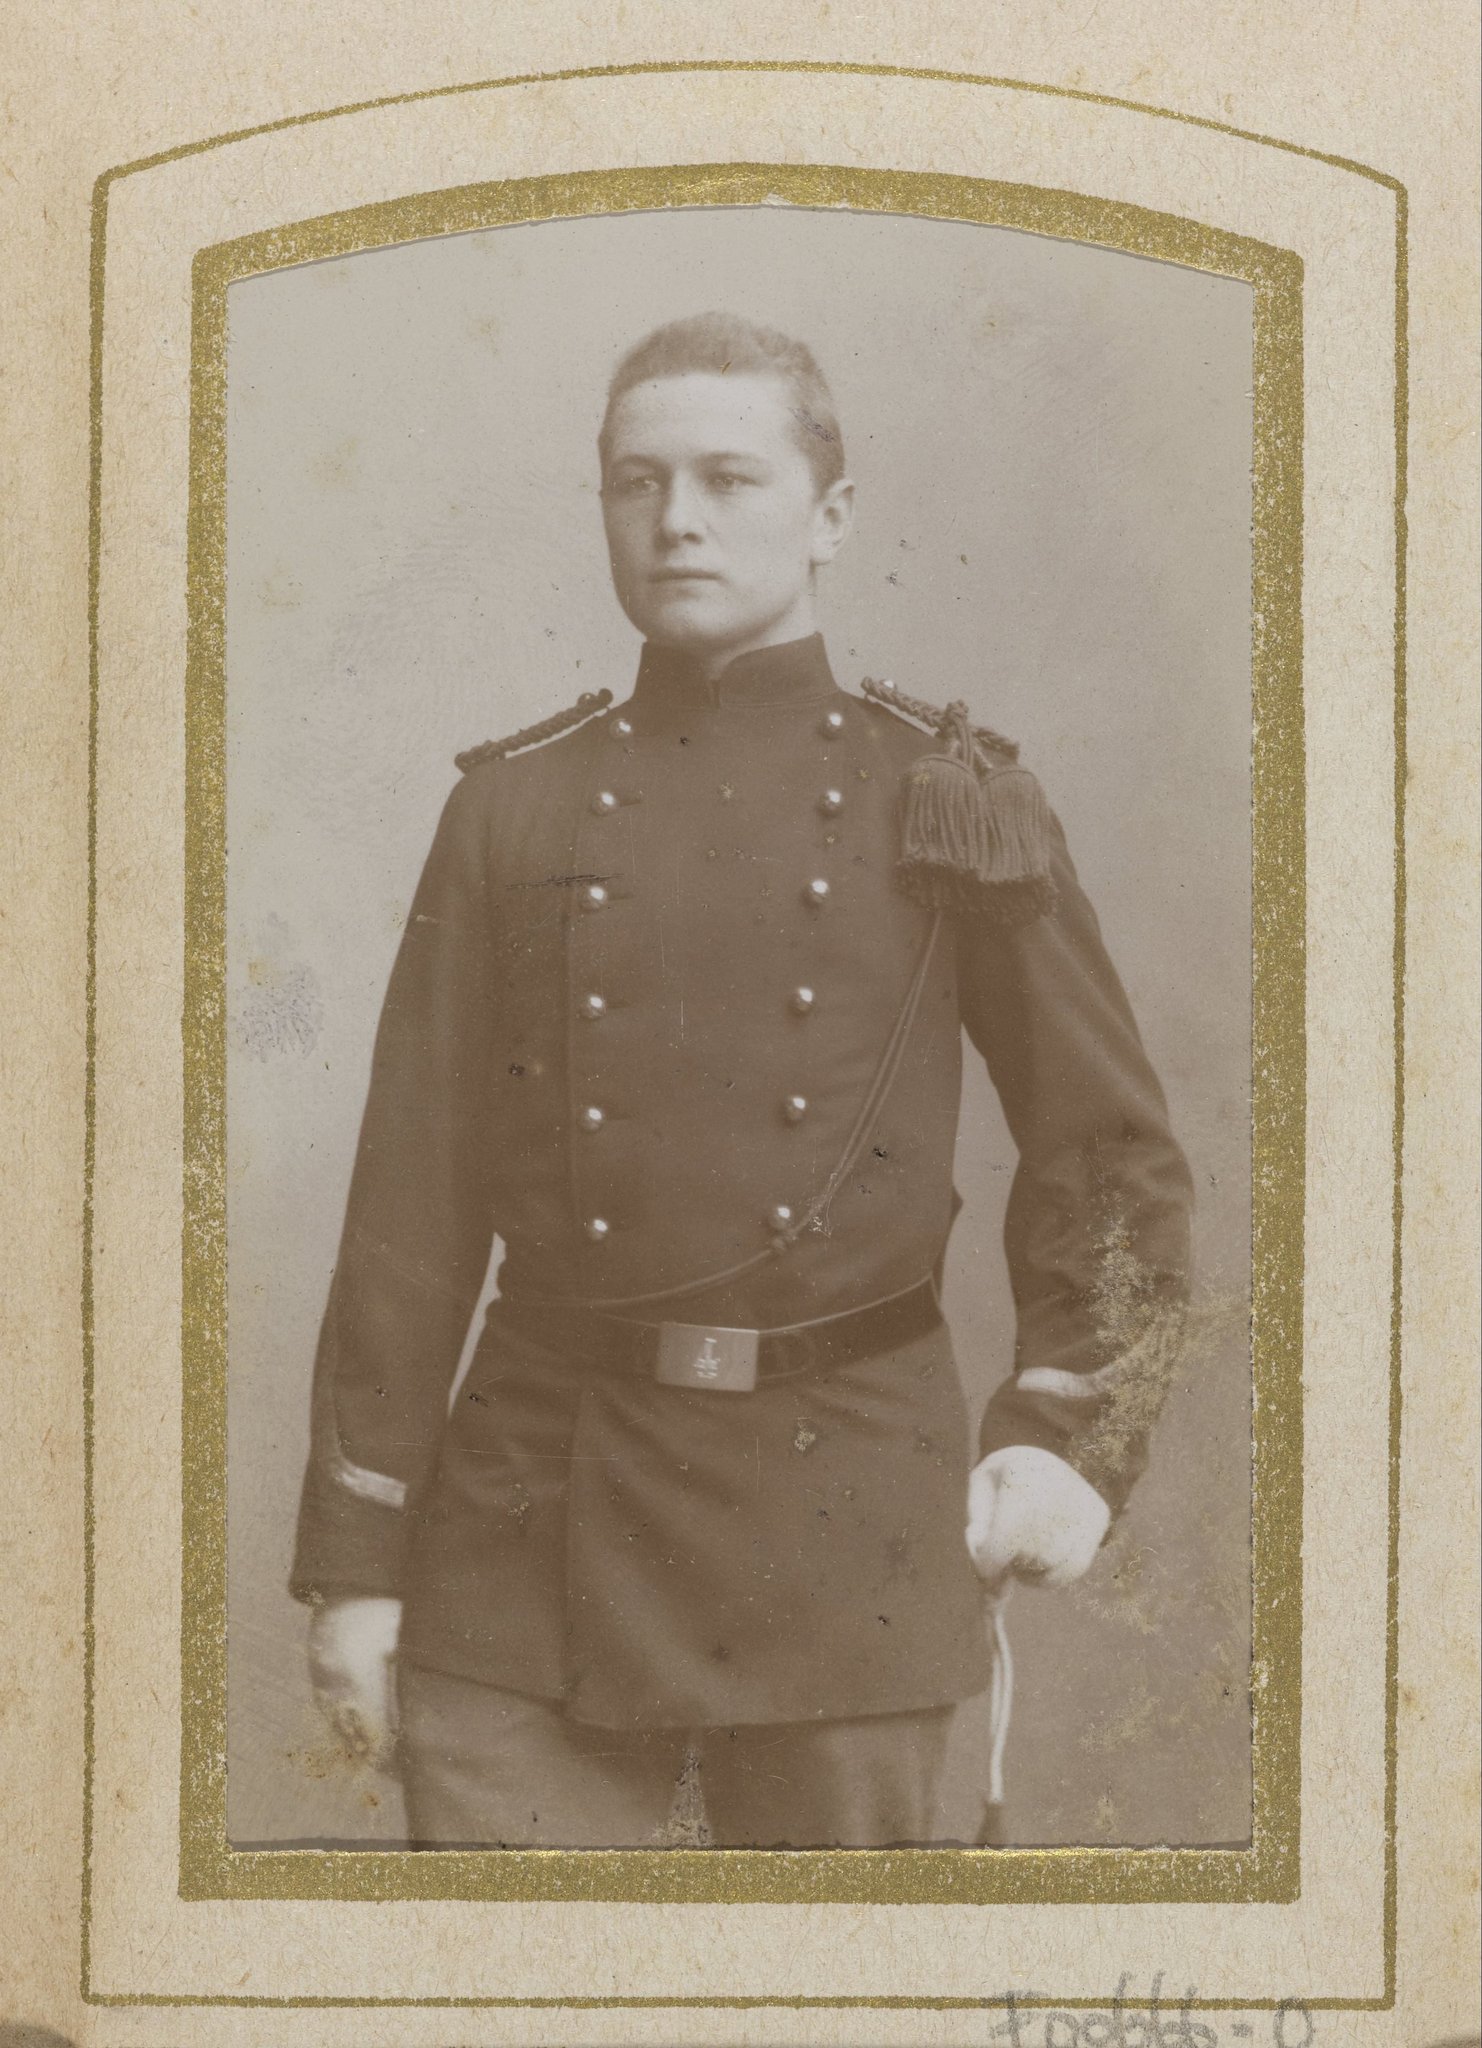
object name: carte de visite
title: Portret van een jonge man in uniform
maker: jan goedeljee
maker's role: fotograaf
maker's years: 1824-1905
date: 1880-1905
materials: cardboard, photographic support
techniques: collodion silver print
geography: leiden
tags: historical persons, (military) uniforms